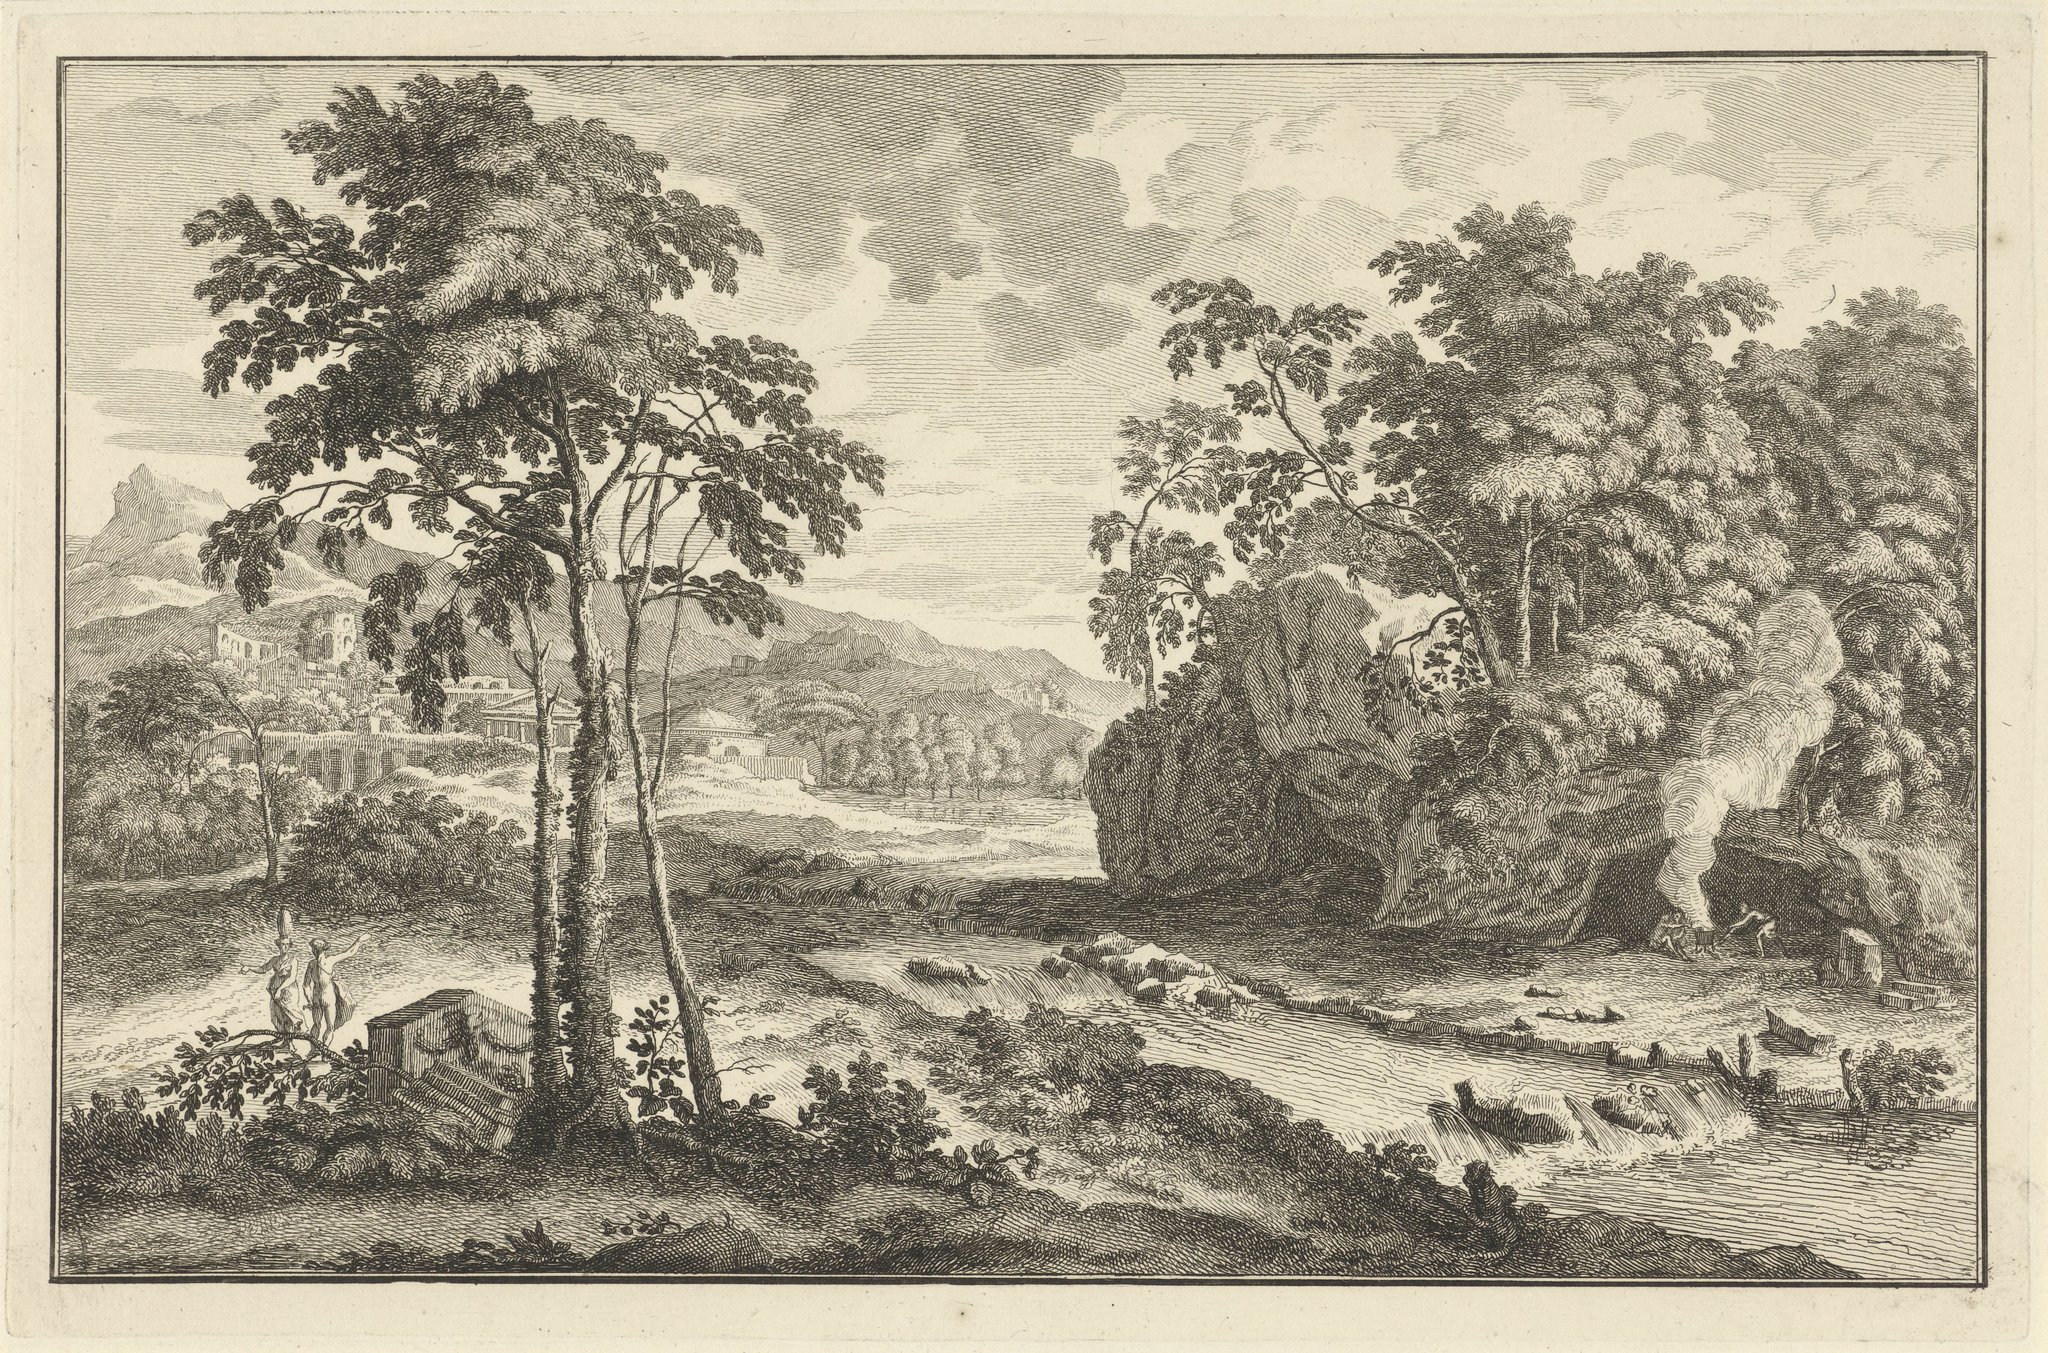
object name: print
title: Italiaanse en Duitse landschappen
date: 1710-1747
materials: paper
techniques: etching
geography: amsterdam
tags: open fire (in general), landscapes with waters, waterscapes, seascapes (in the temperate zone)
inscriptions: collector's mark: Lugt 240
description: Arcadisch rivierlandschap met links van de rivier twee vrouwen in gesprek, rechts twee mannen die een vuur maken. De prent maakt deel uit van een 40-delige serie prenten met voorstellingen van Italiaanse en Duitse landschappen.